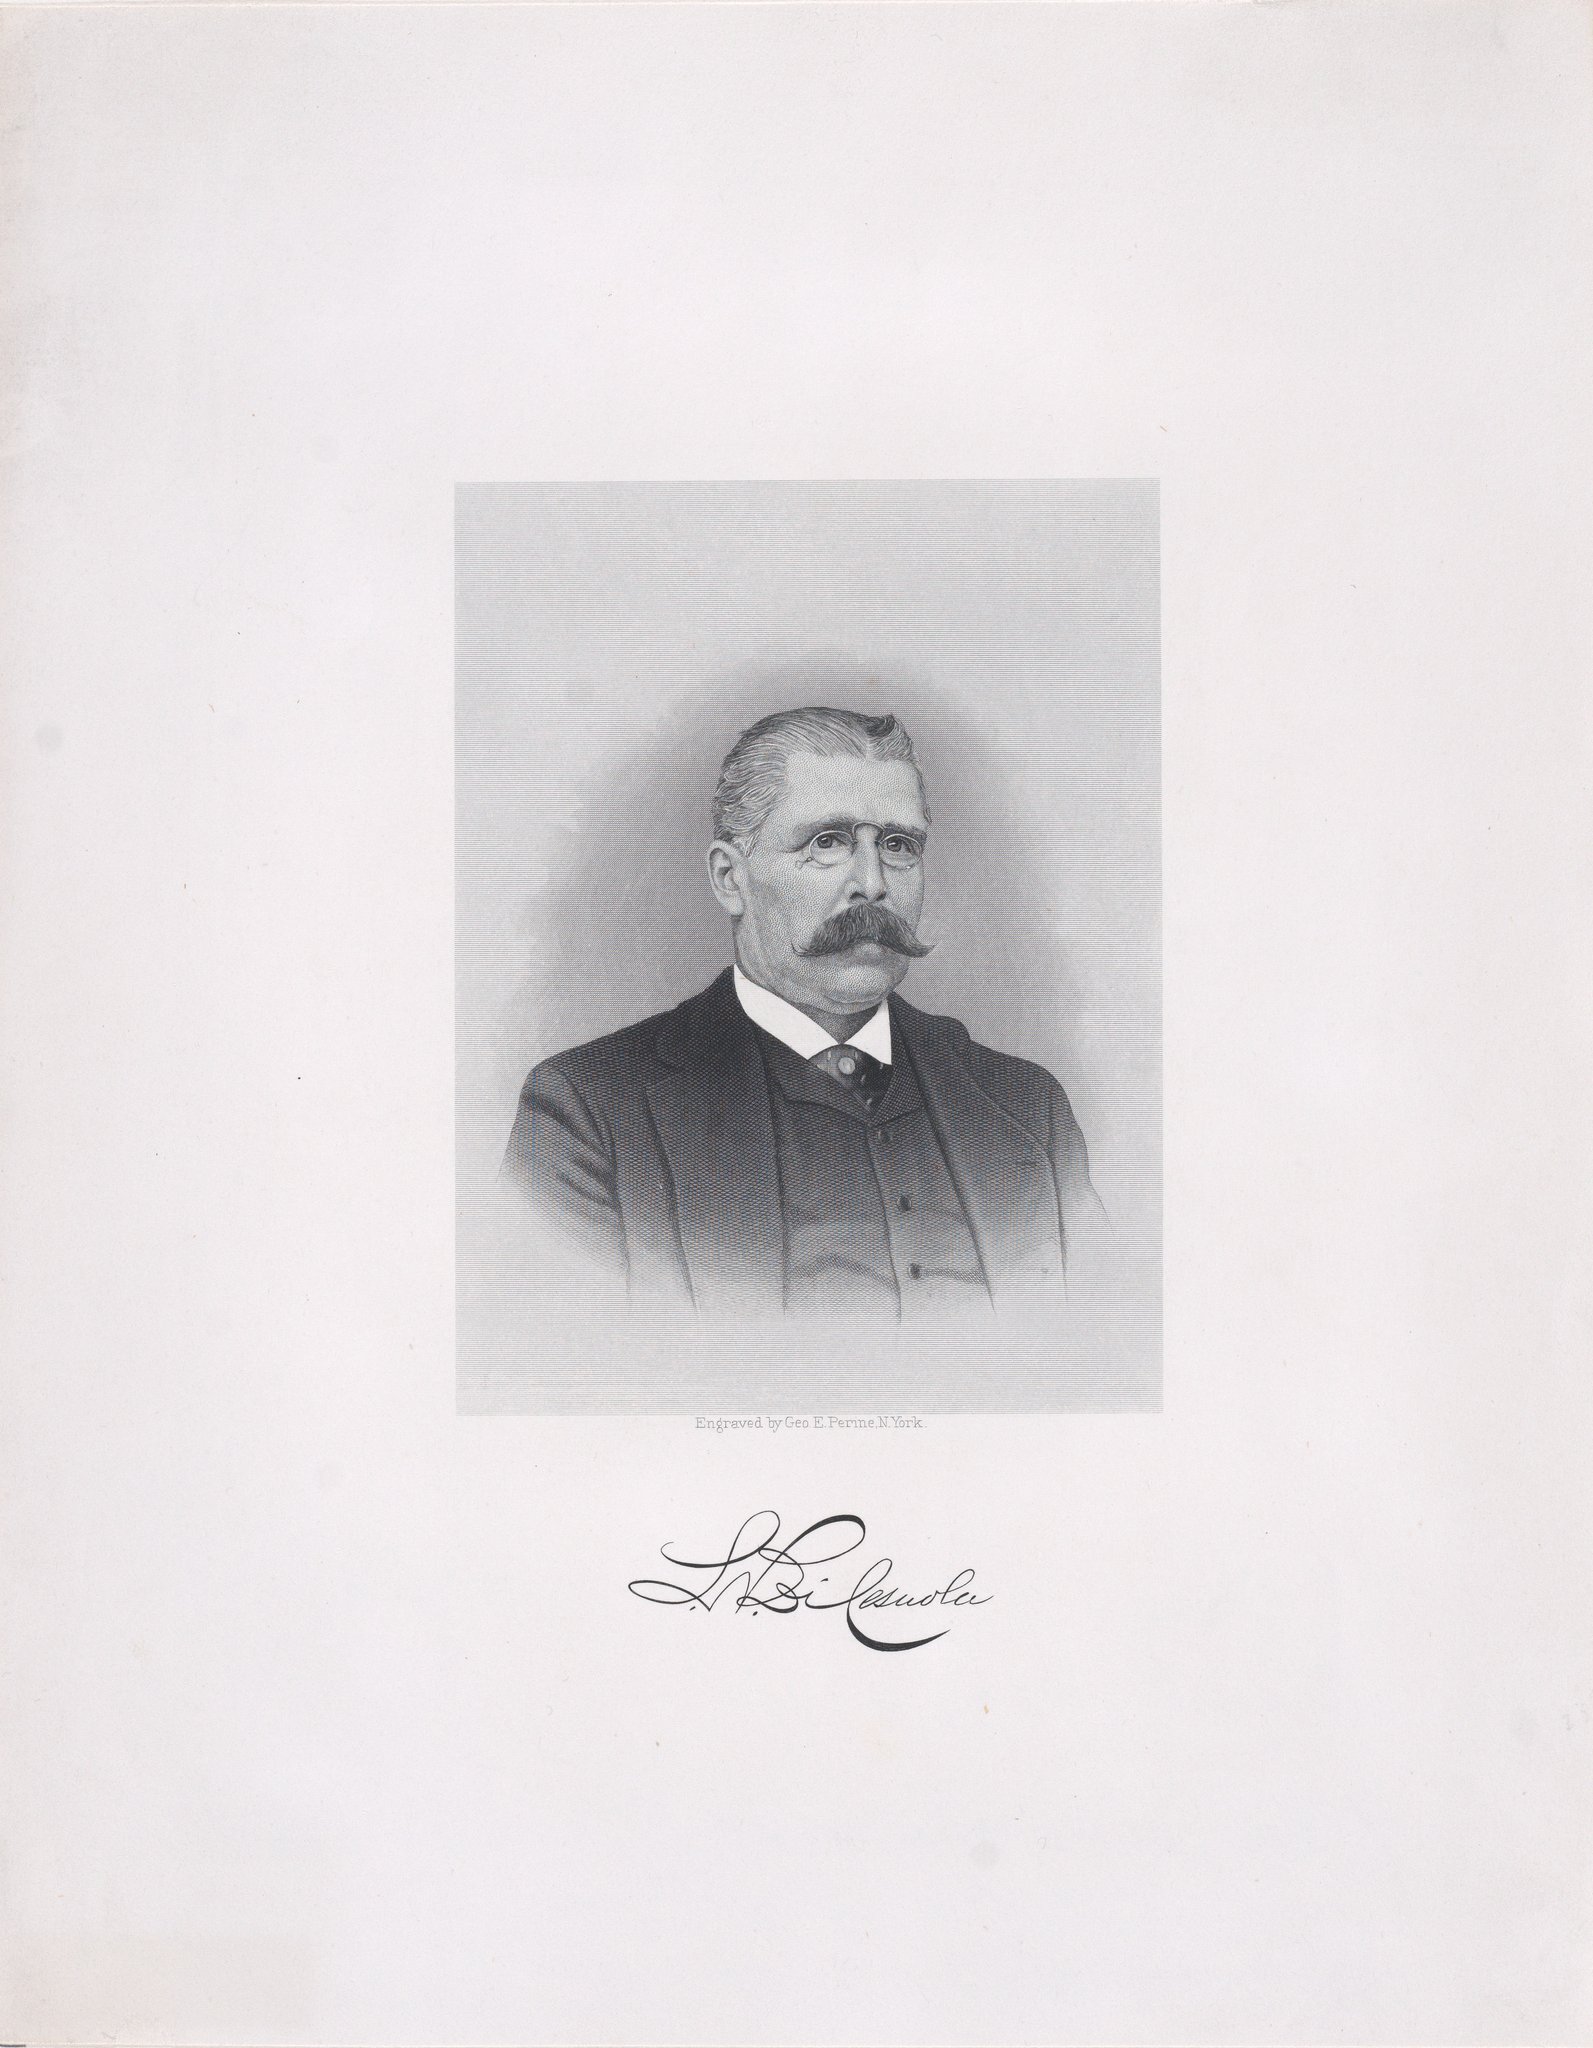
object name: print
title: Luigi Palma di Cesnola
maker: george edward perine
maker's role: artist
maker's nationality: american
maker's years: 1837-1885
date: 1890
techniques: engraving, photography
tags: men,portraits